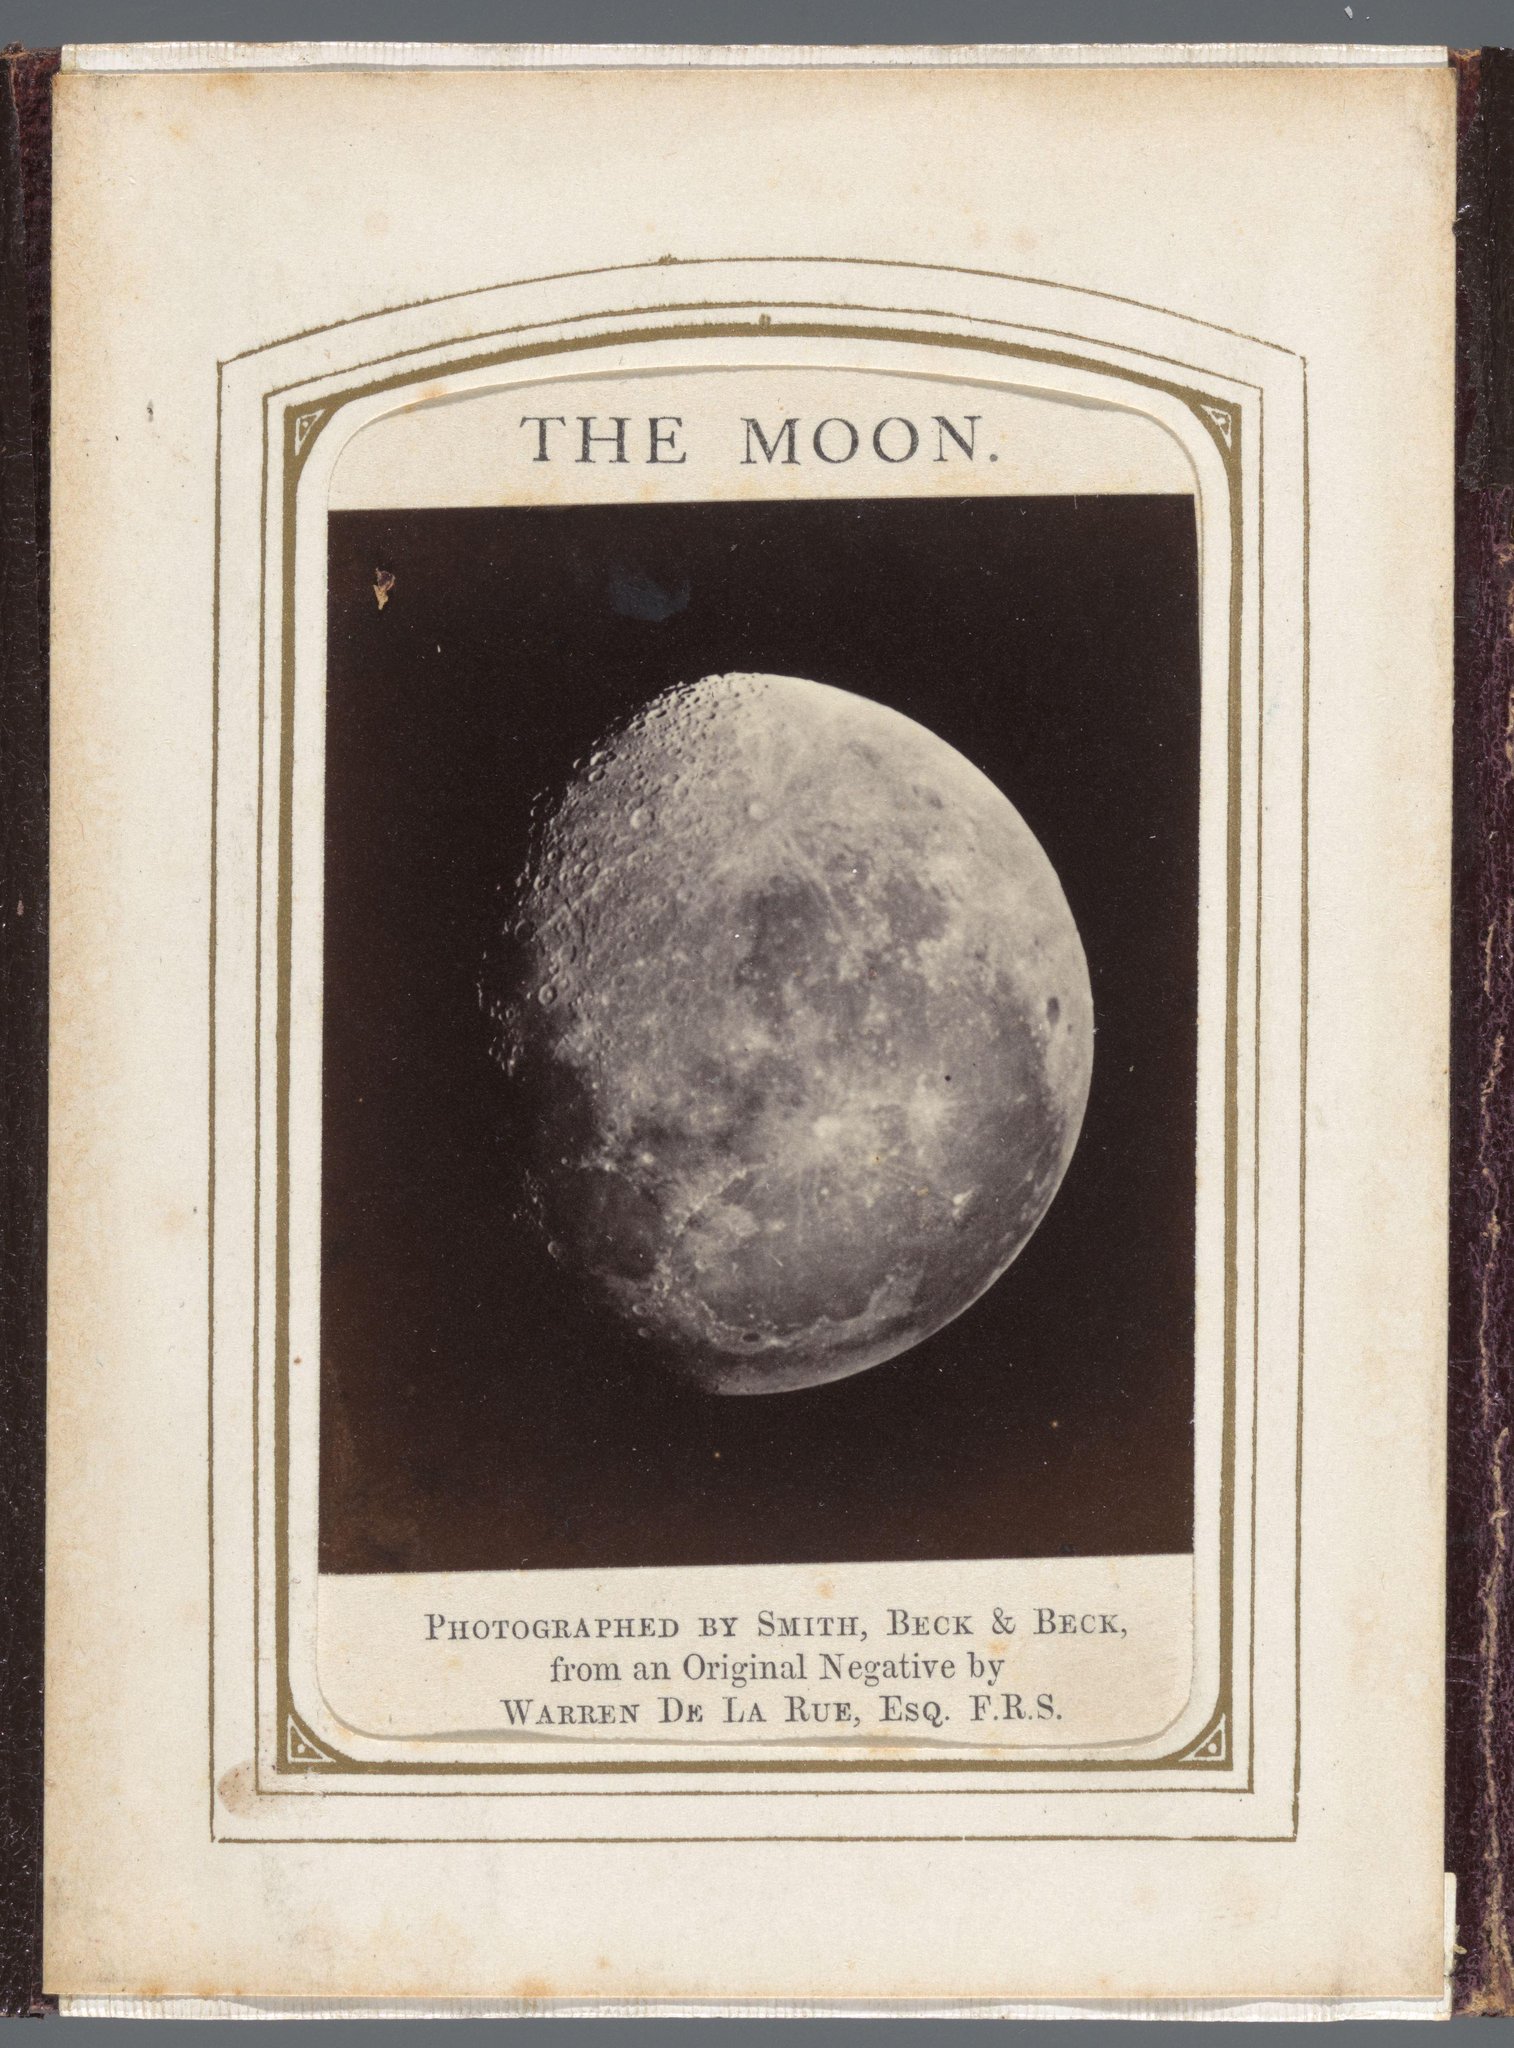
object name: album leaf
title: The Moon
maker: warren de la rue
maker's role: astronoom, fotograaf, scheikundige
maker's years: 1815-1889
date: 1866-1880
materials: cardboard, paper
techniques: albumen print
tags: waxing moon, i.e. facing this way: ), moon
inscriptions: inscription: ‘PHOTOGRAPHED BY SMITH, BECK & BECK,/ from an Original Negative by/WARREN DE LA RUE, ESQ, F.R.S.’